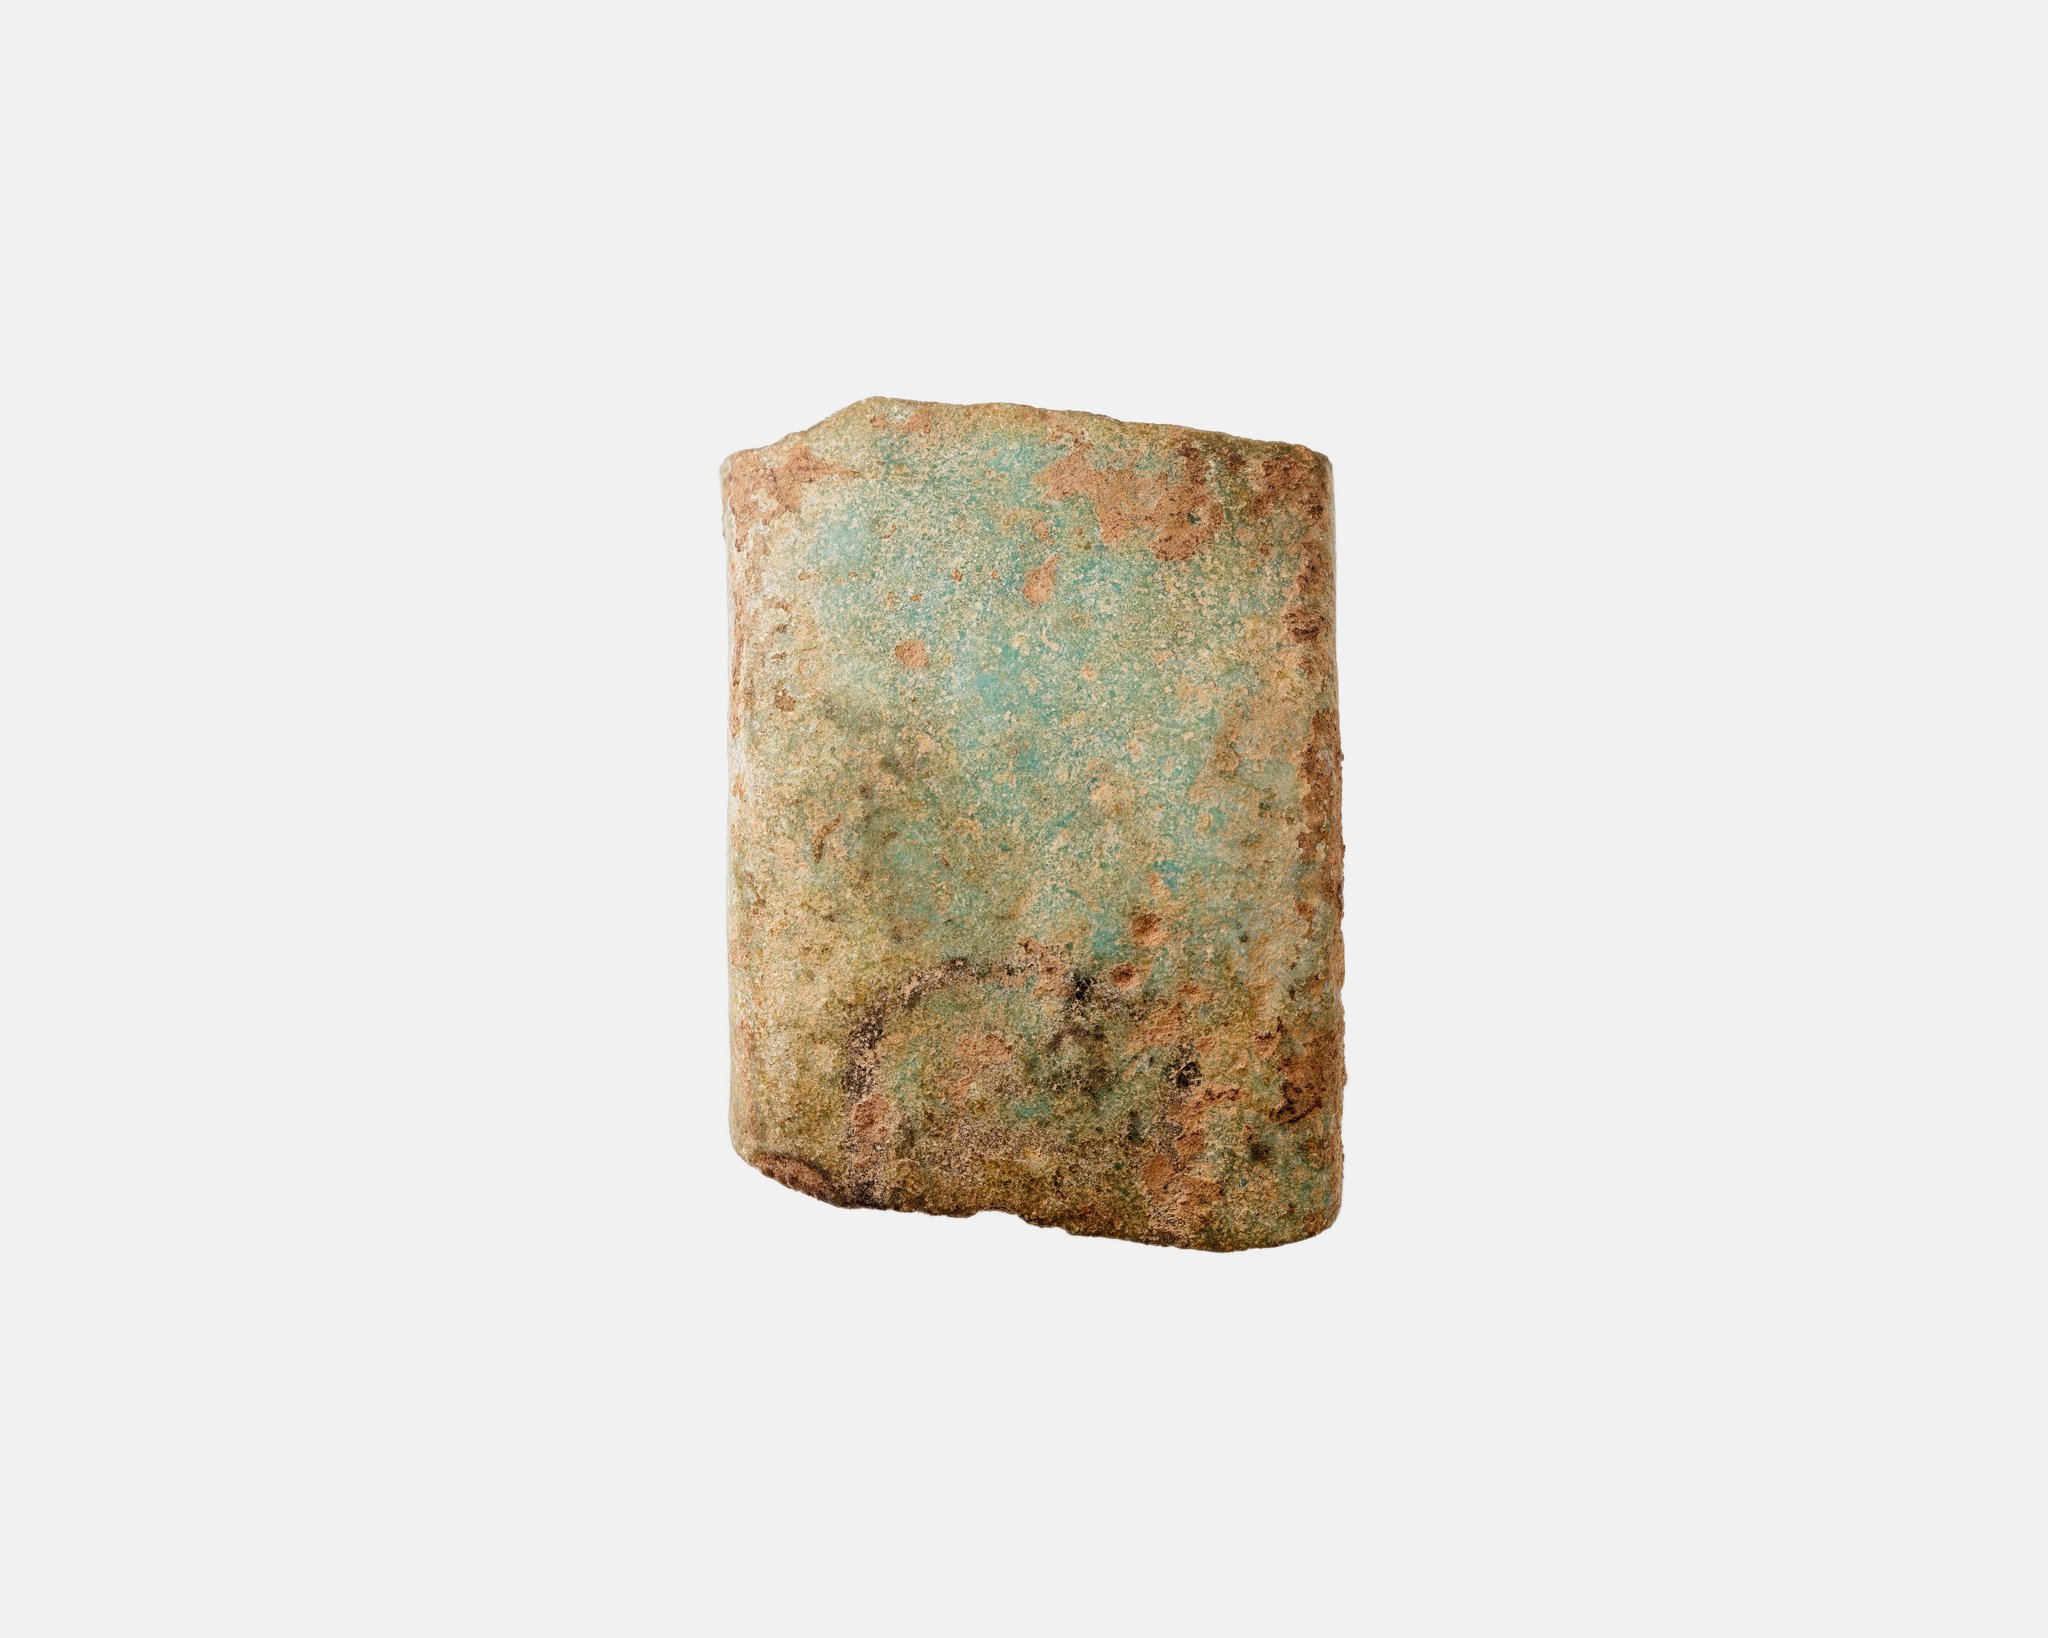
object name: votive bracelet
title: Fragment of a votive bracelet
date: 1295-1070 BCE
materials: faience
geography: egypt